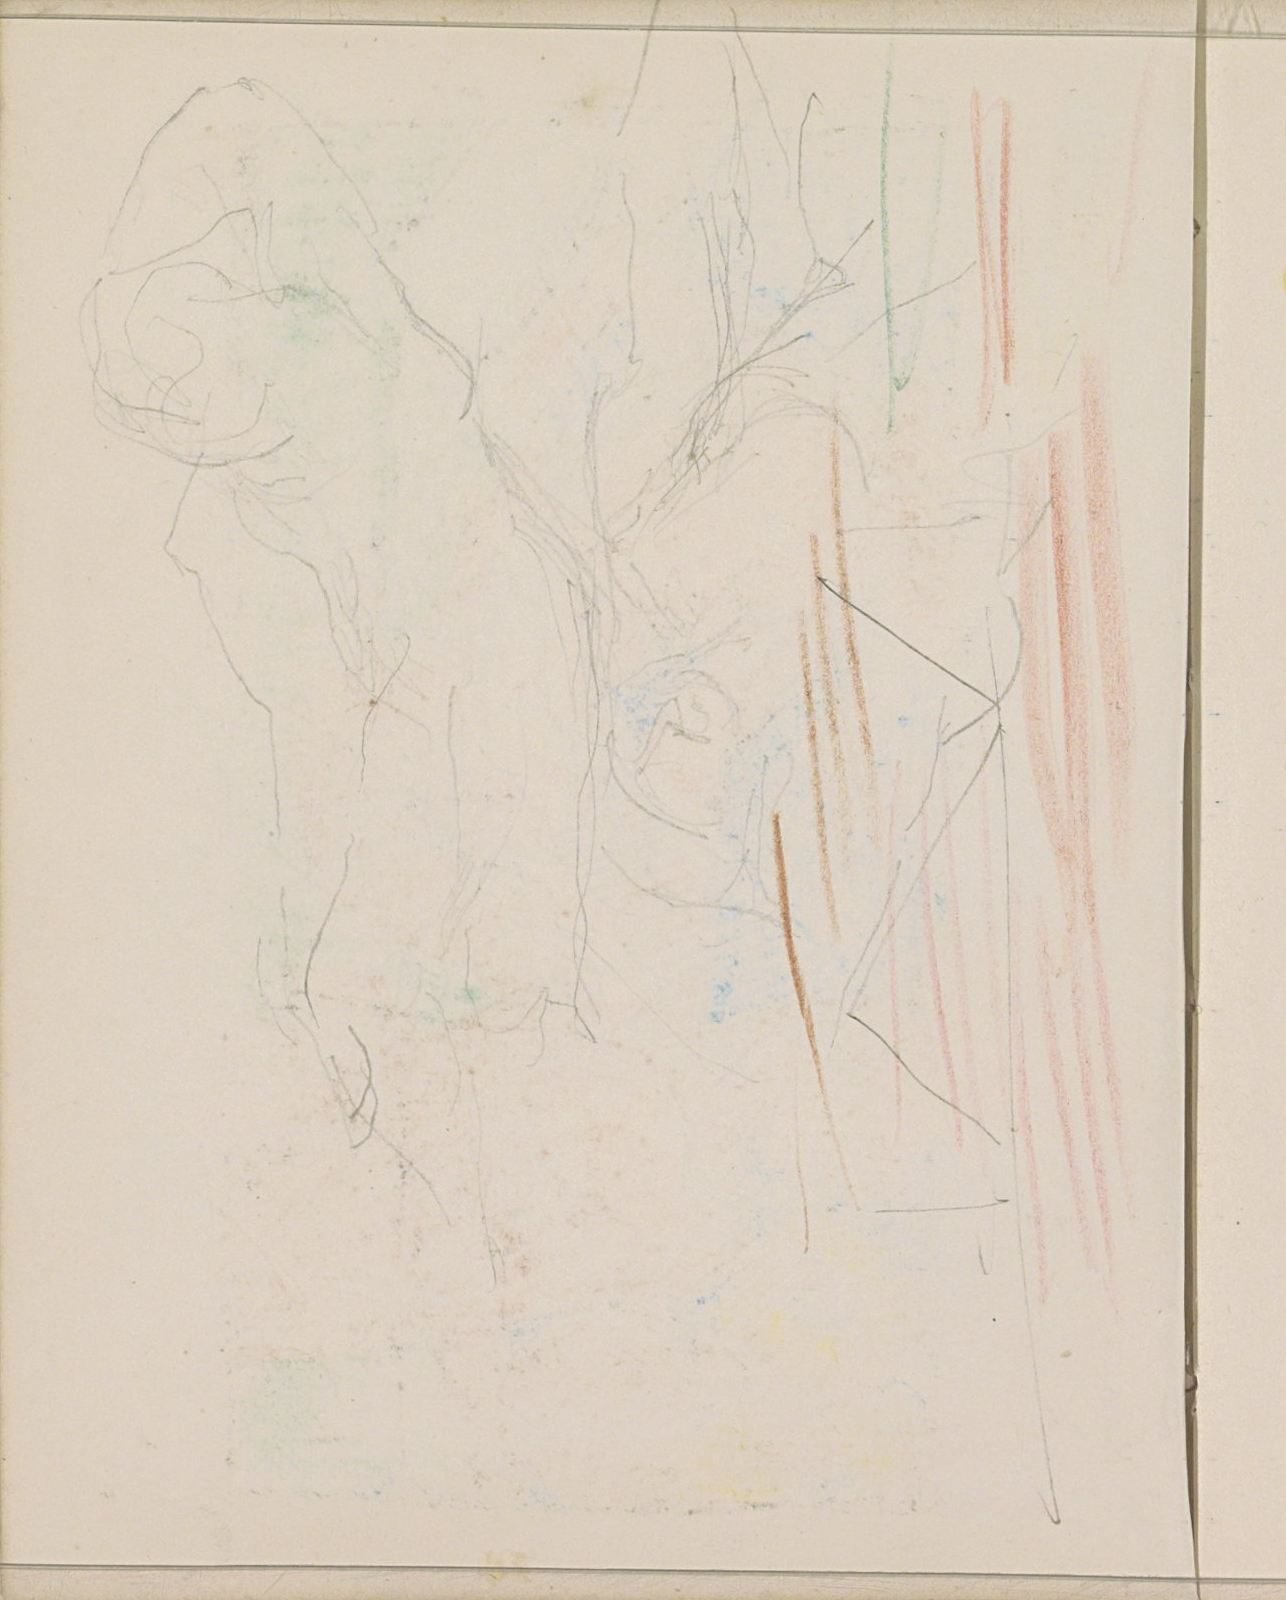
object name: sketchbook leaf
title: Liggende naakte vrouw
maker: reijer stolk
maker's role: draughtsman, print maker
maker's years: 1896-1945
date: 1916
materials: paper, pencil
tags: lying figure - aa - female human figure (+ nude human being)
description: Blad 32 verso uit een schetsboek met 72 bladen.